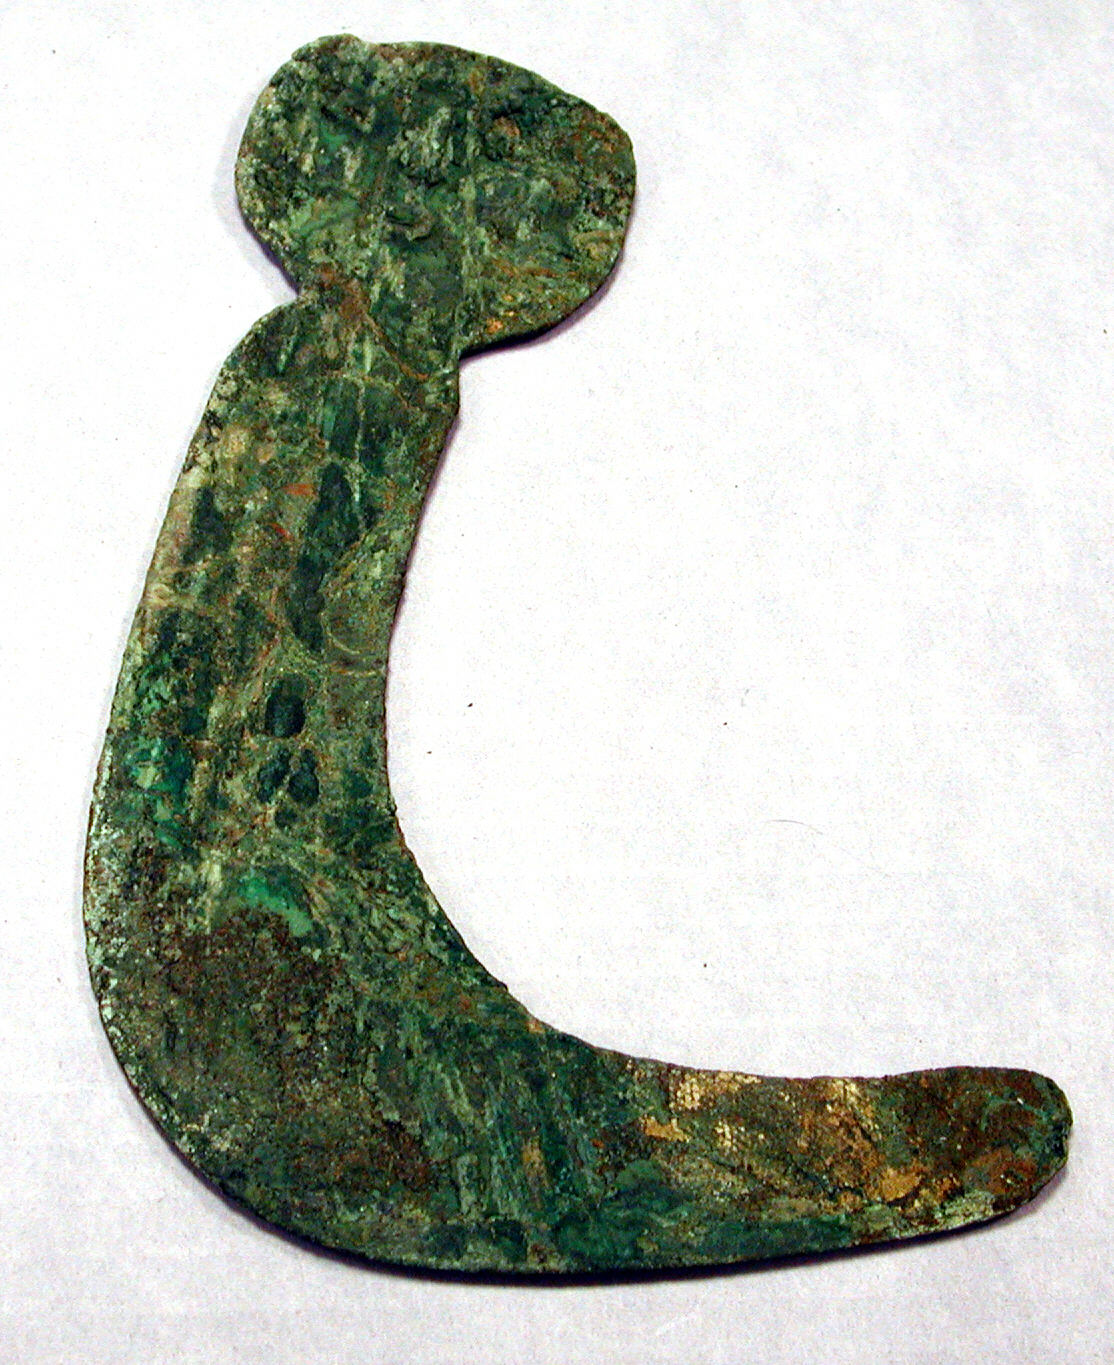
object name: knife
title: Copper Knife with Sickle Shaped Blade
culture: vicús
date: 300 BCE-200 CE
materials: copper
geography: peru